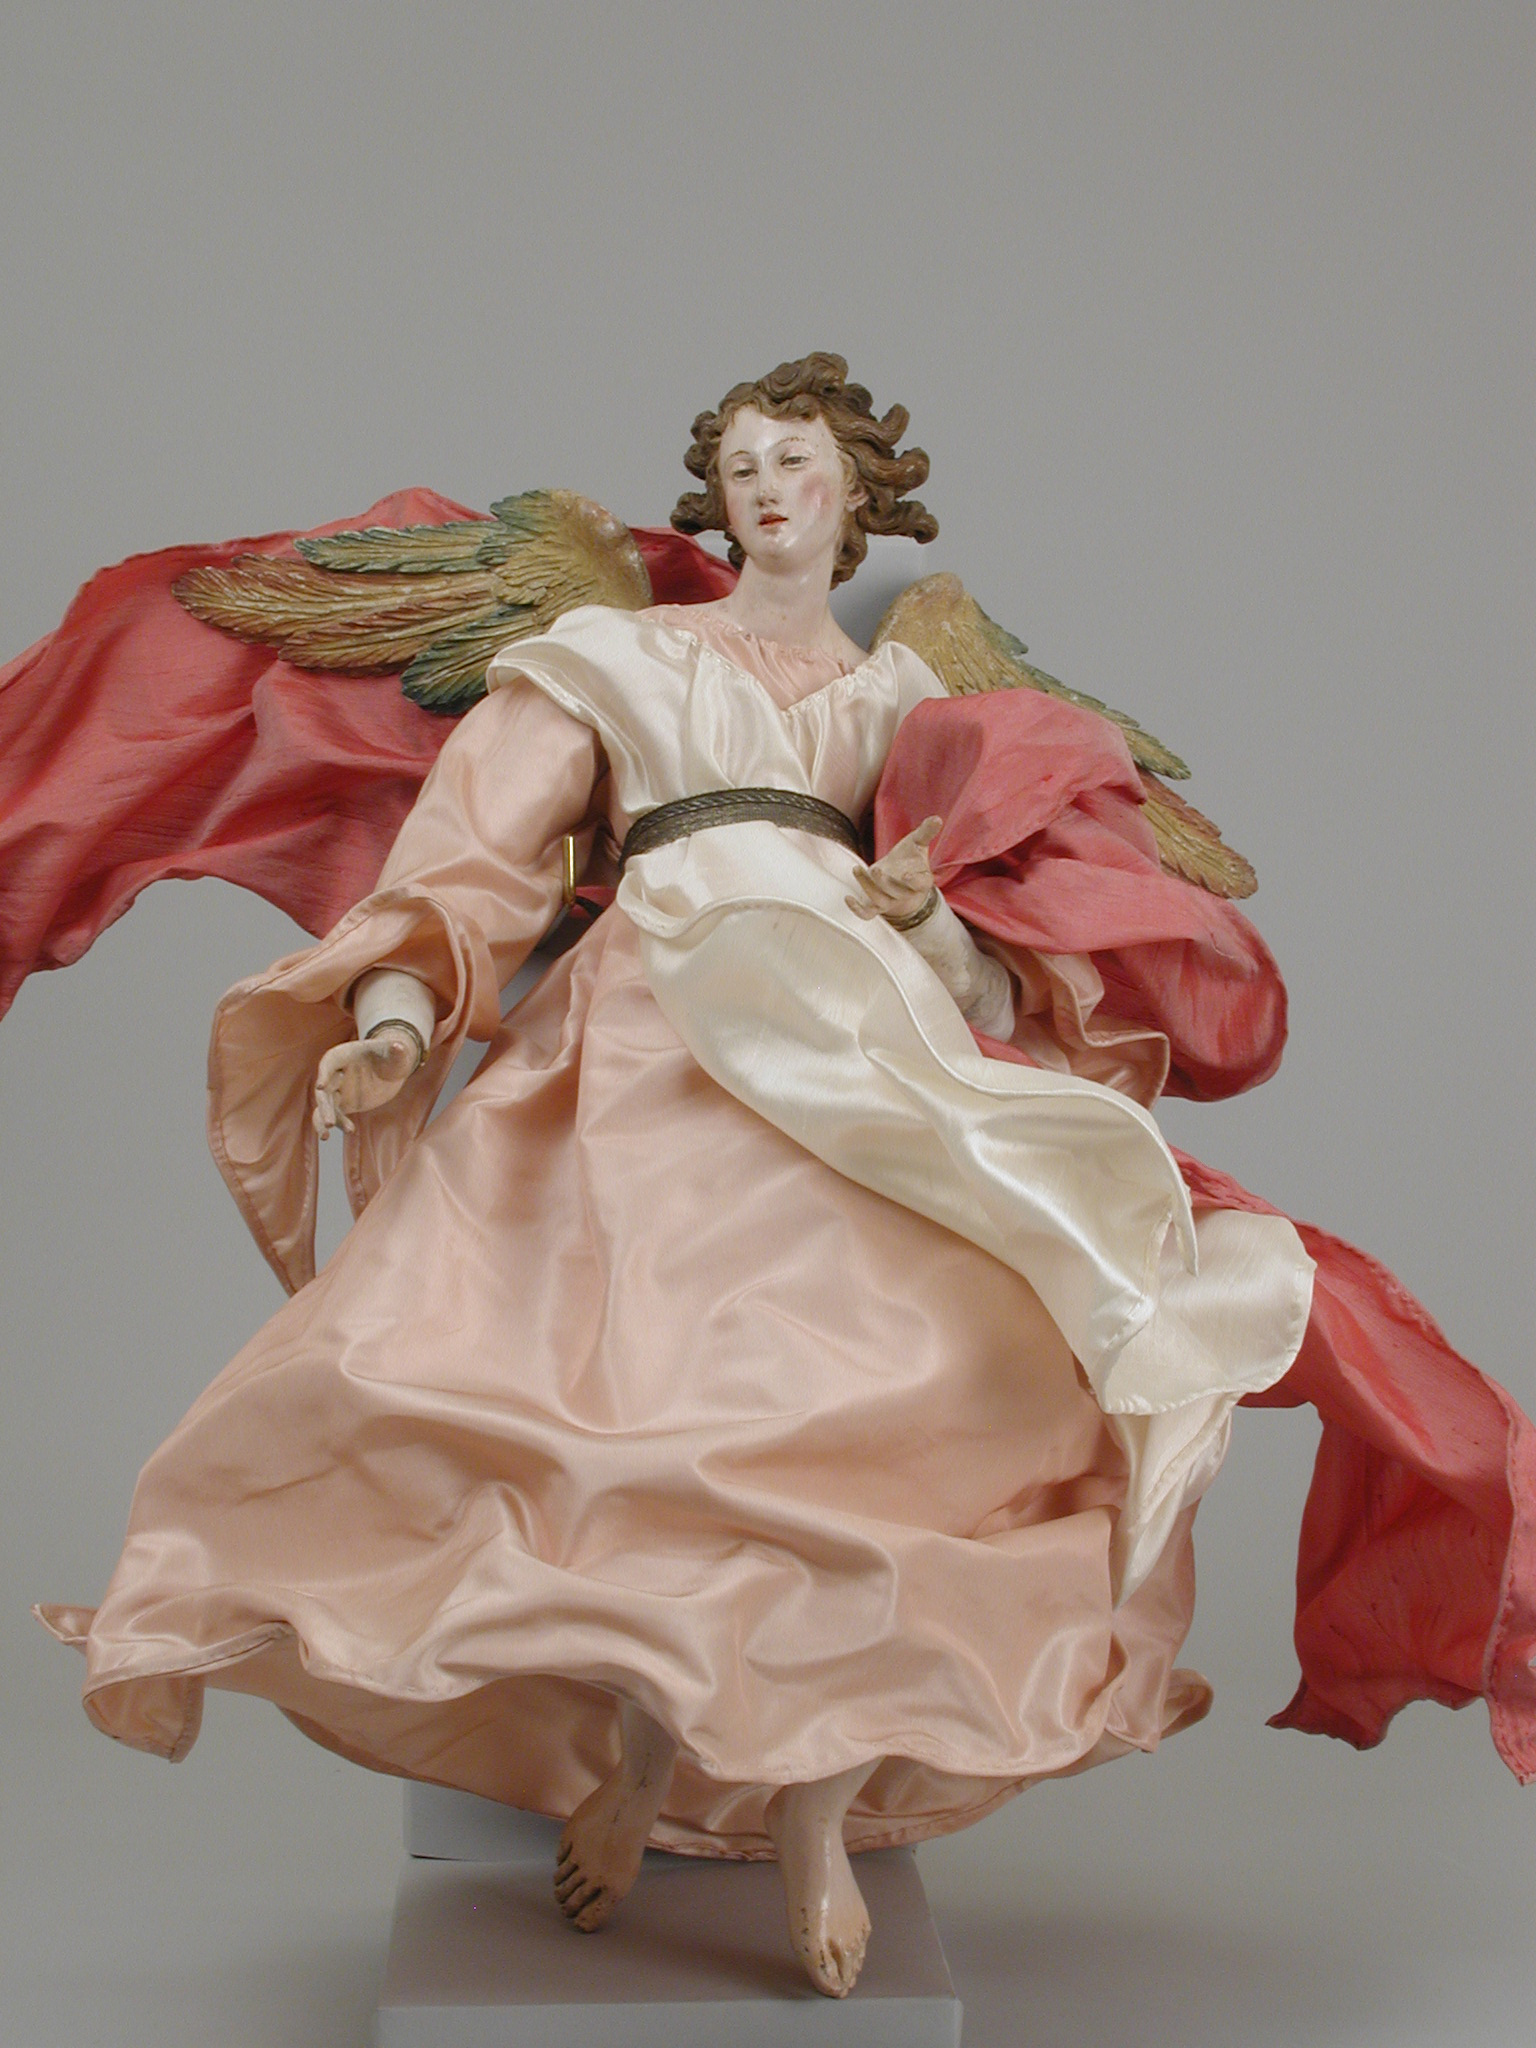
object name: crèche figure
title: Angel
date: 1751-1800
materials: terracotta, fiber, metal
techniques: polychrome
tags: angels